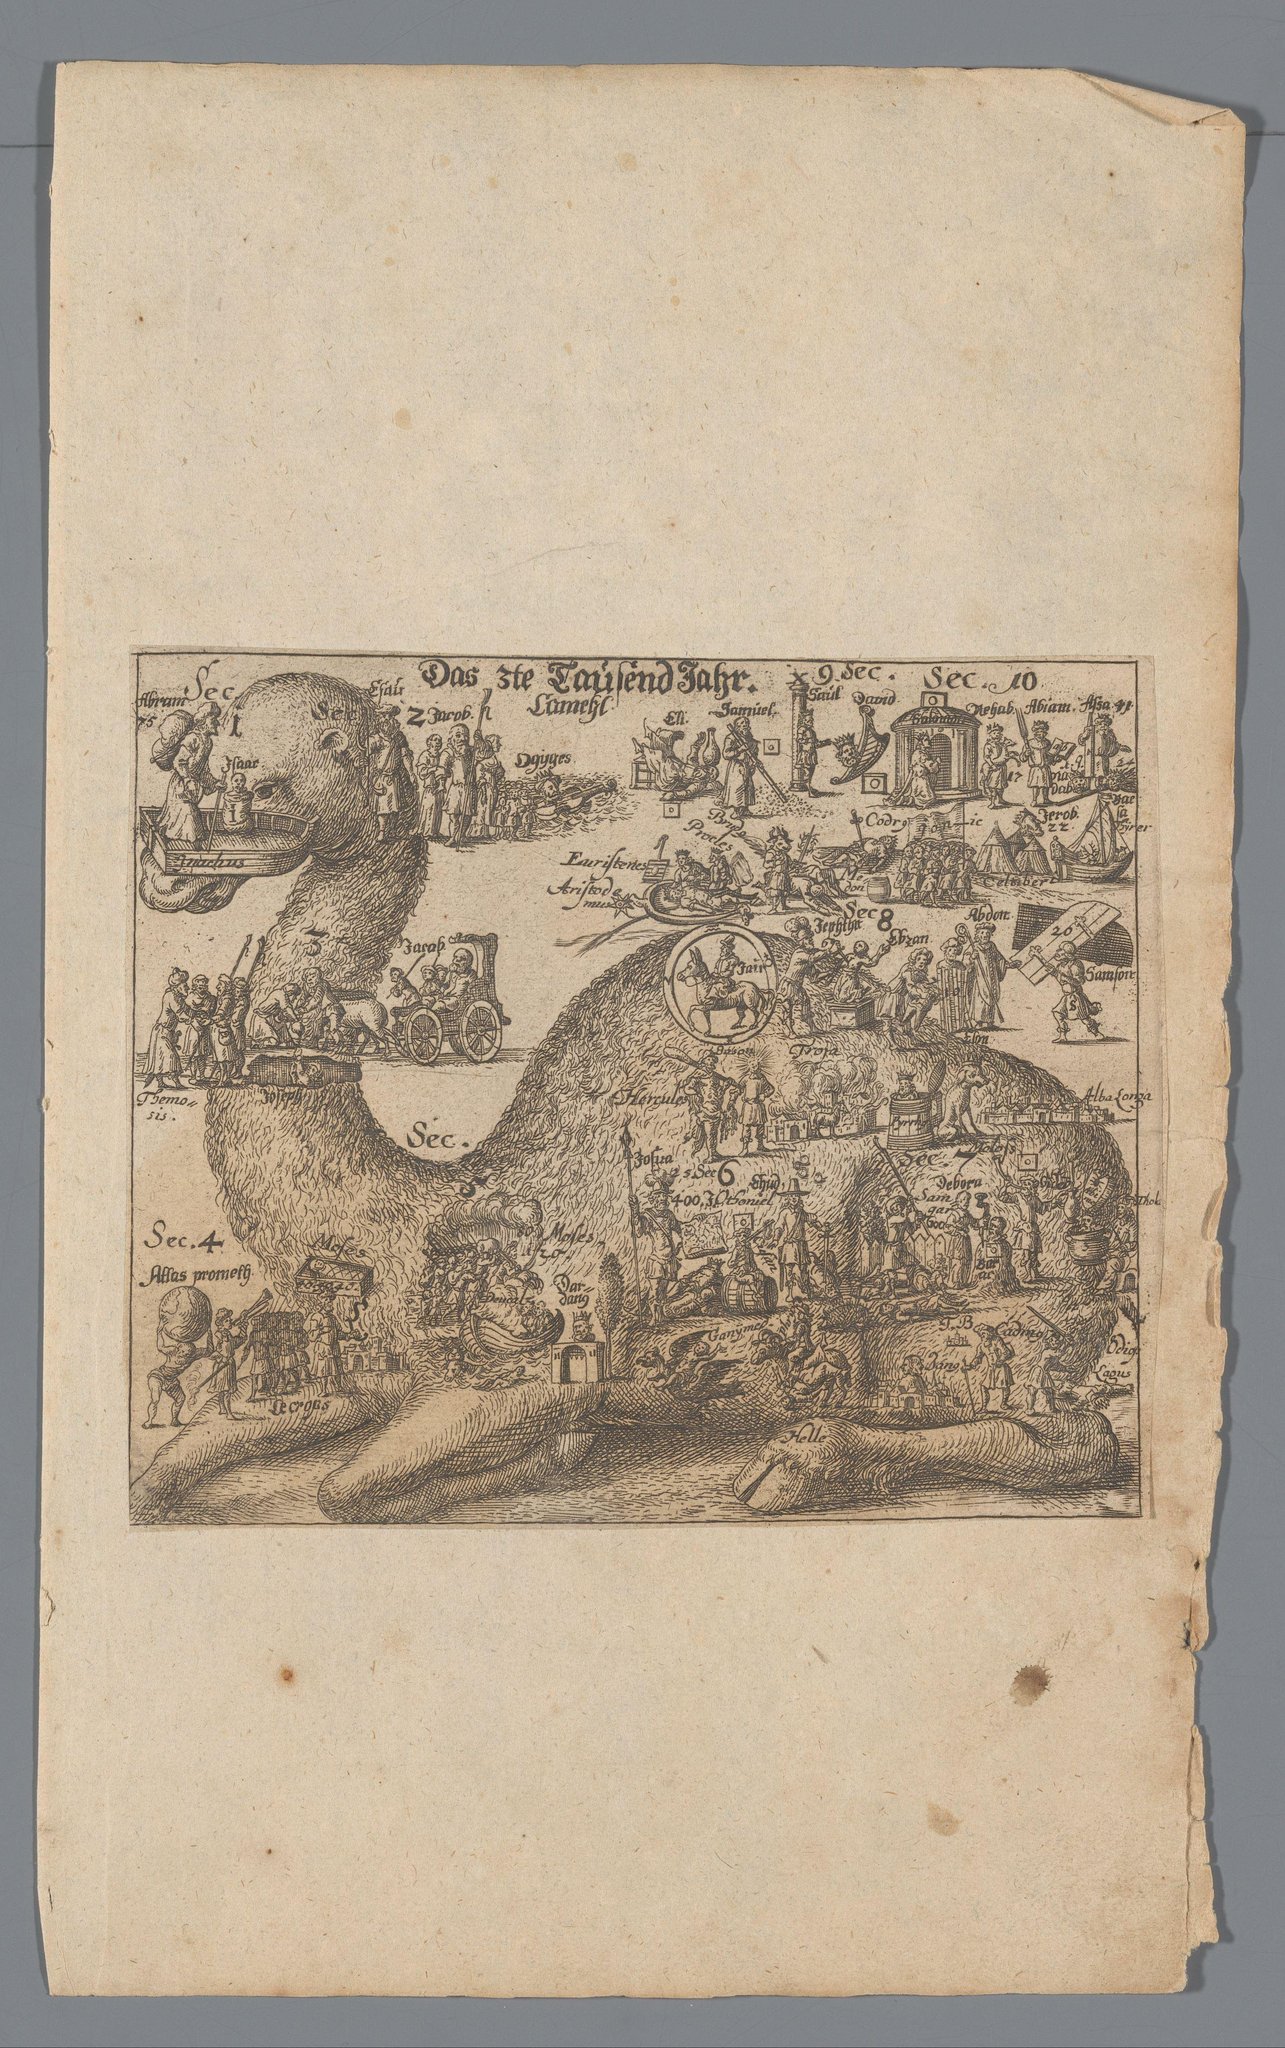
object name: print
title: Derde millenium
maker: Anonymous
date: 1667-1672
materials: paper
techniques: engraving, etching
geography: germany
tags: hoofed animals: dromedary, old testament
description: Prenten afkomstig uit een editie van: Johannes Buno, Historische Bilder/ Darinnen Idea Historiae Universalis : Eine kurtze Summarische Abbildung Der fürnehmsten Geist- und Weltlichen Geschichte durch die vier Monarchien ..., eerst uitgegeven door Bartold Elers in Lüneburg in 1672.